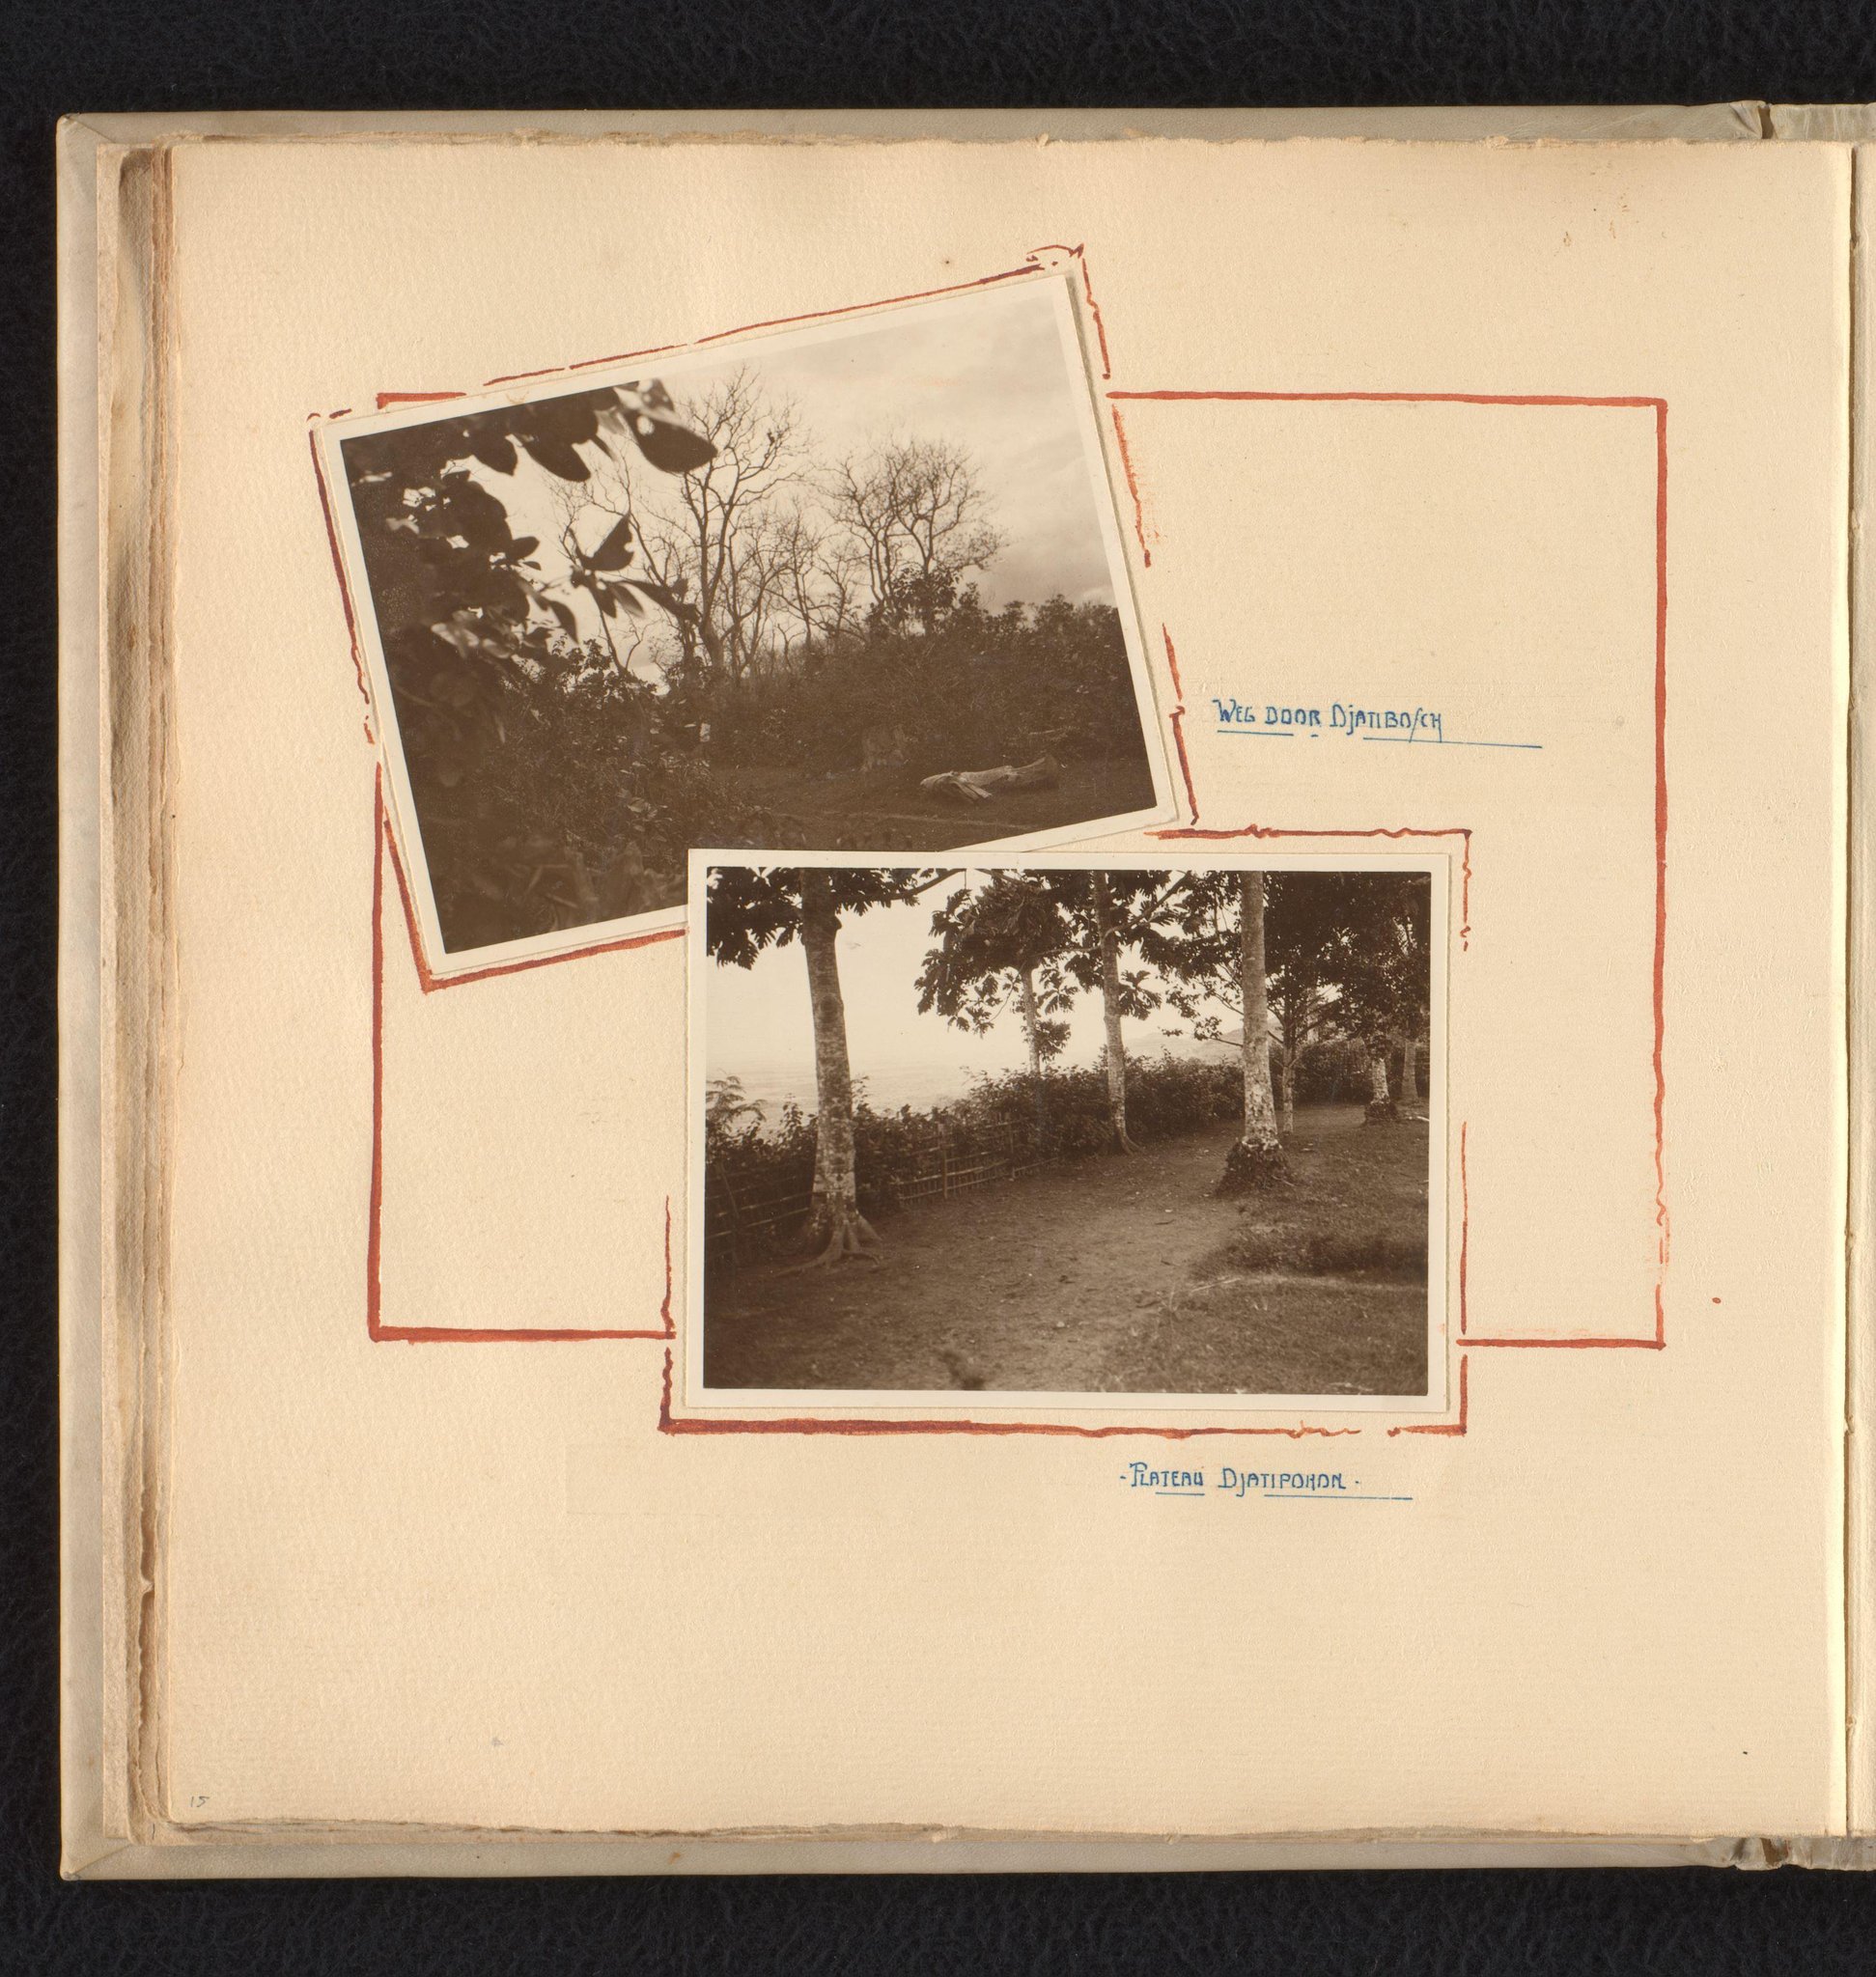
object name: album leaf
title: Landschappen in Jati Pohon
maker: Anonymous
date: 1910-1928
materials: paper, photographic support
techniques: drawing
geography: grobogan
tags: landscapes in tropical and sub-tropical regions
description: Albumblad met twee foto's van landschappen in Jati Pohon (Djatipohon) in Grobogan. Het blad is versierd met randwerk om de foto's. Onderdeel van het fotoalbum aangeboden aan J. Habbema door het Binnenlandsch Bestuur Corps van het Regentschap Grobogan, bij het beëindigen van zijn bestuur over het Regentschap, waarschijnlijk in 1928.